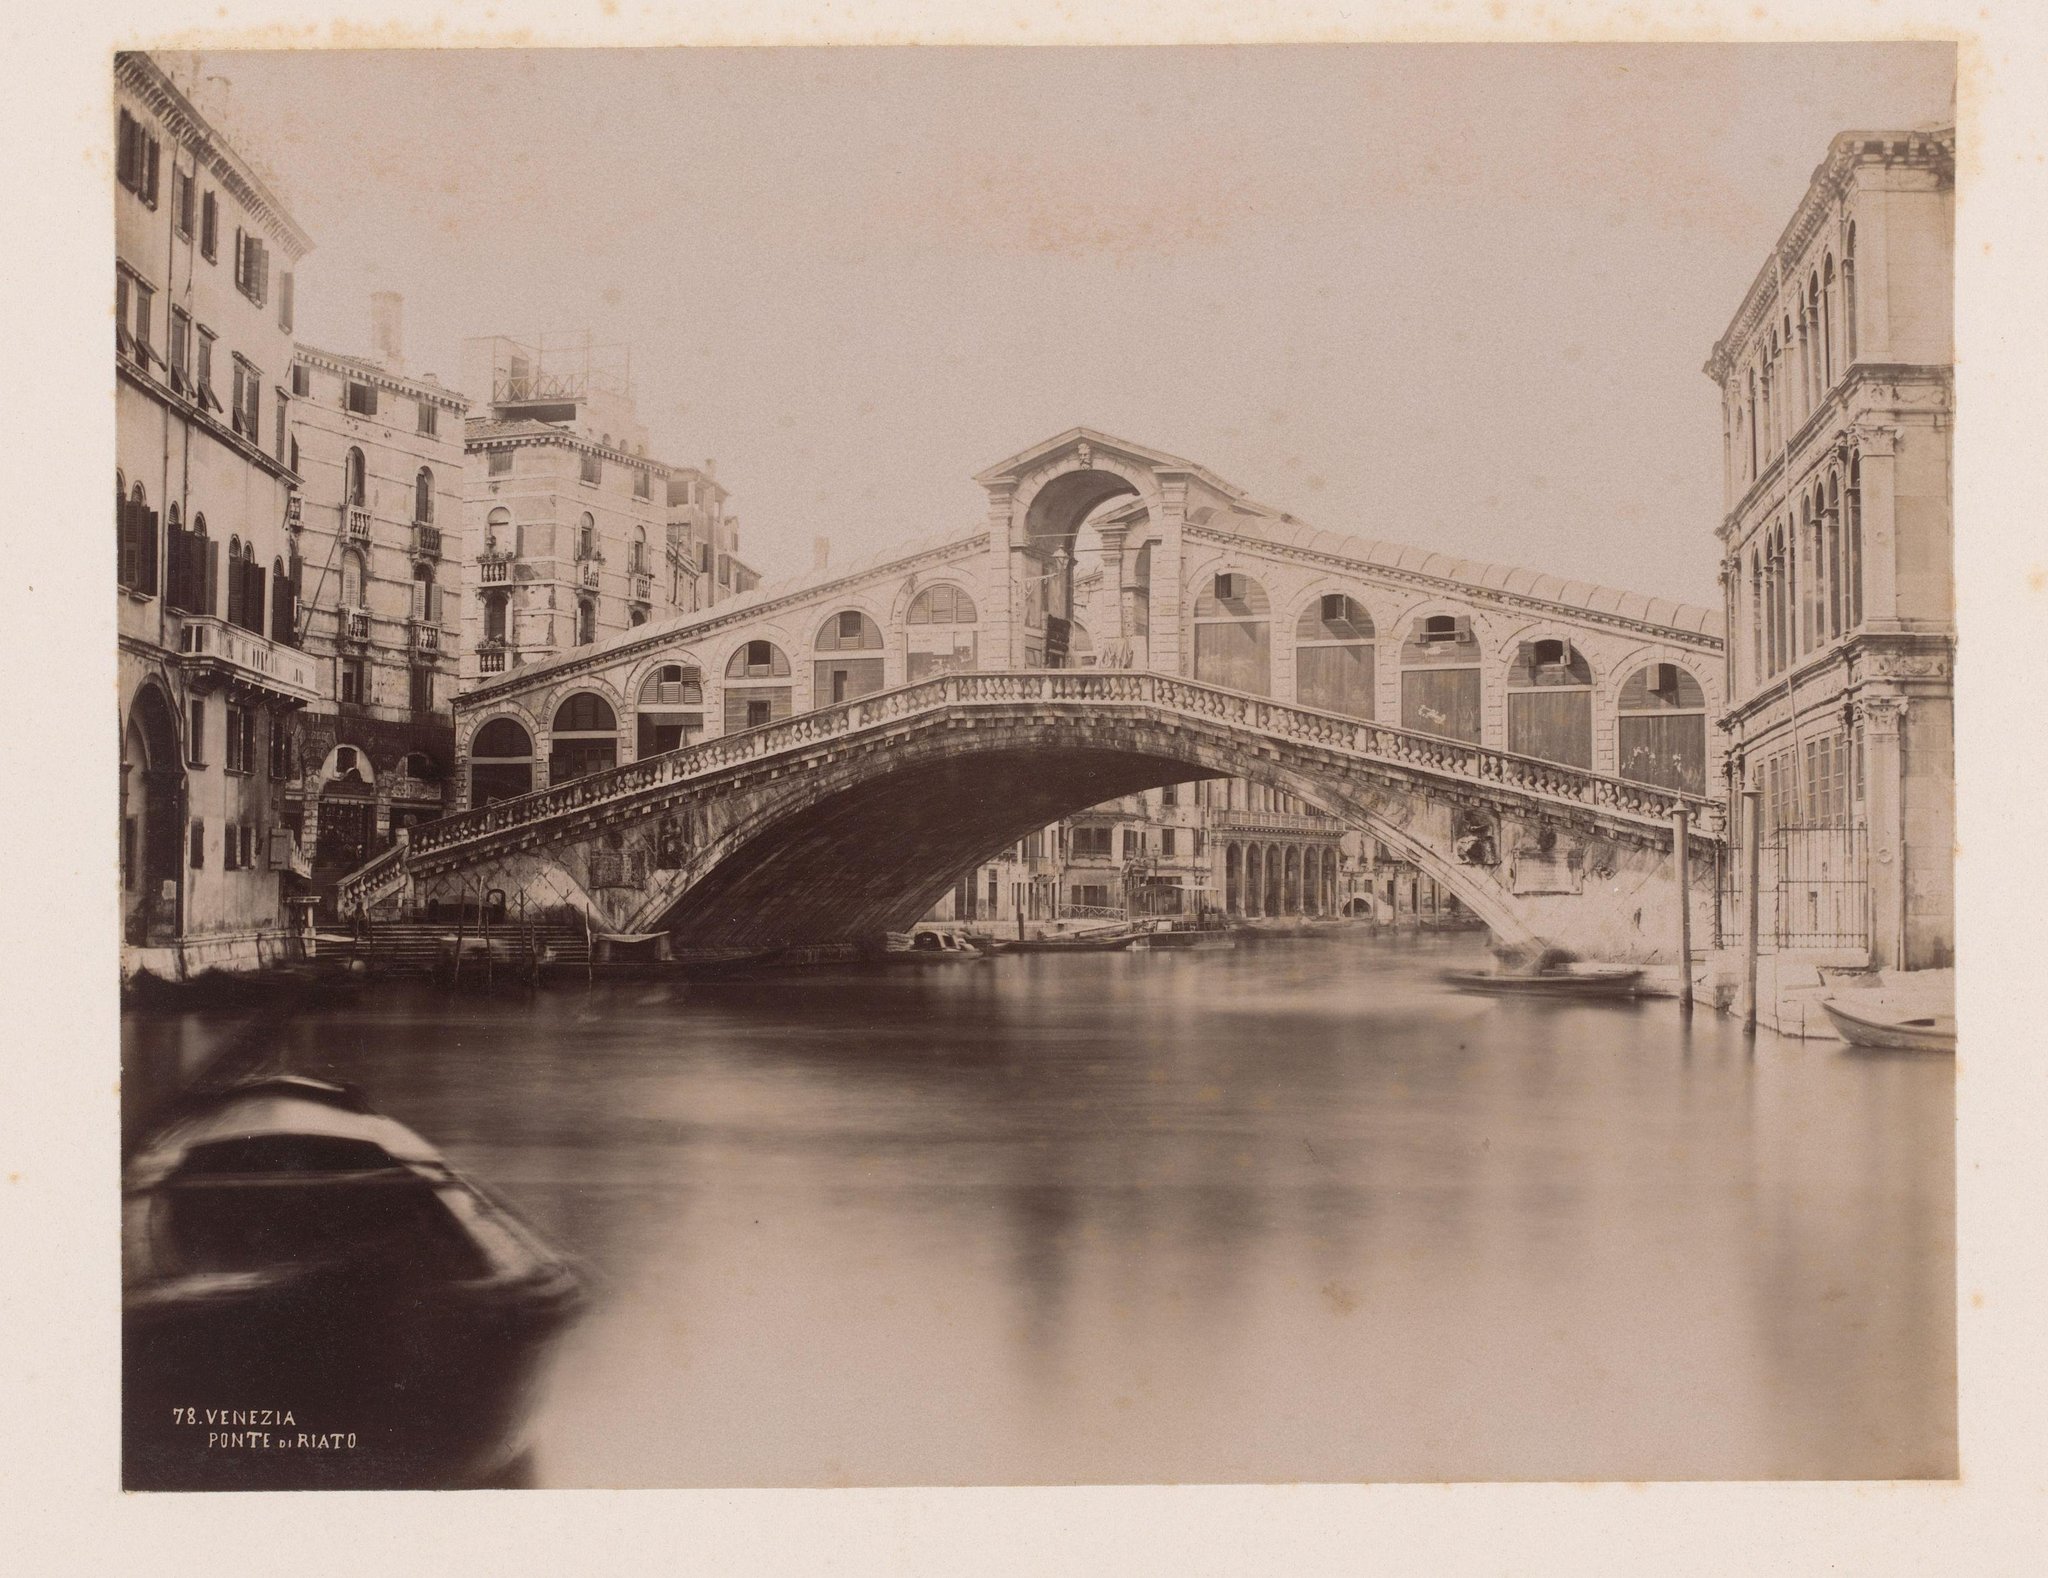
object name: photograph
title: Gezicht op de Rialtobrug te Venetië, Italië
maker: Anonymous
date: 1851-1900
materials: cardboard, paper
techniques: albumen print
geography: venice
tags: bridge in city across river, canal, etc.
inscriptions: number: ‘78.’